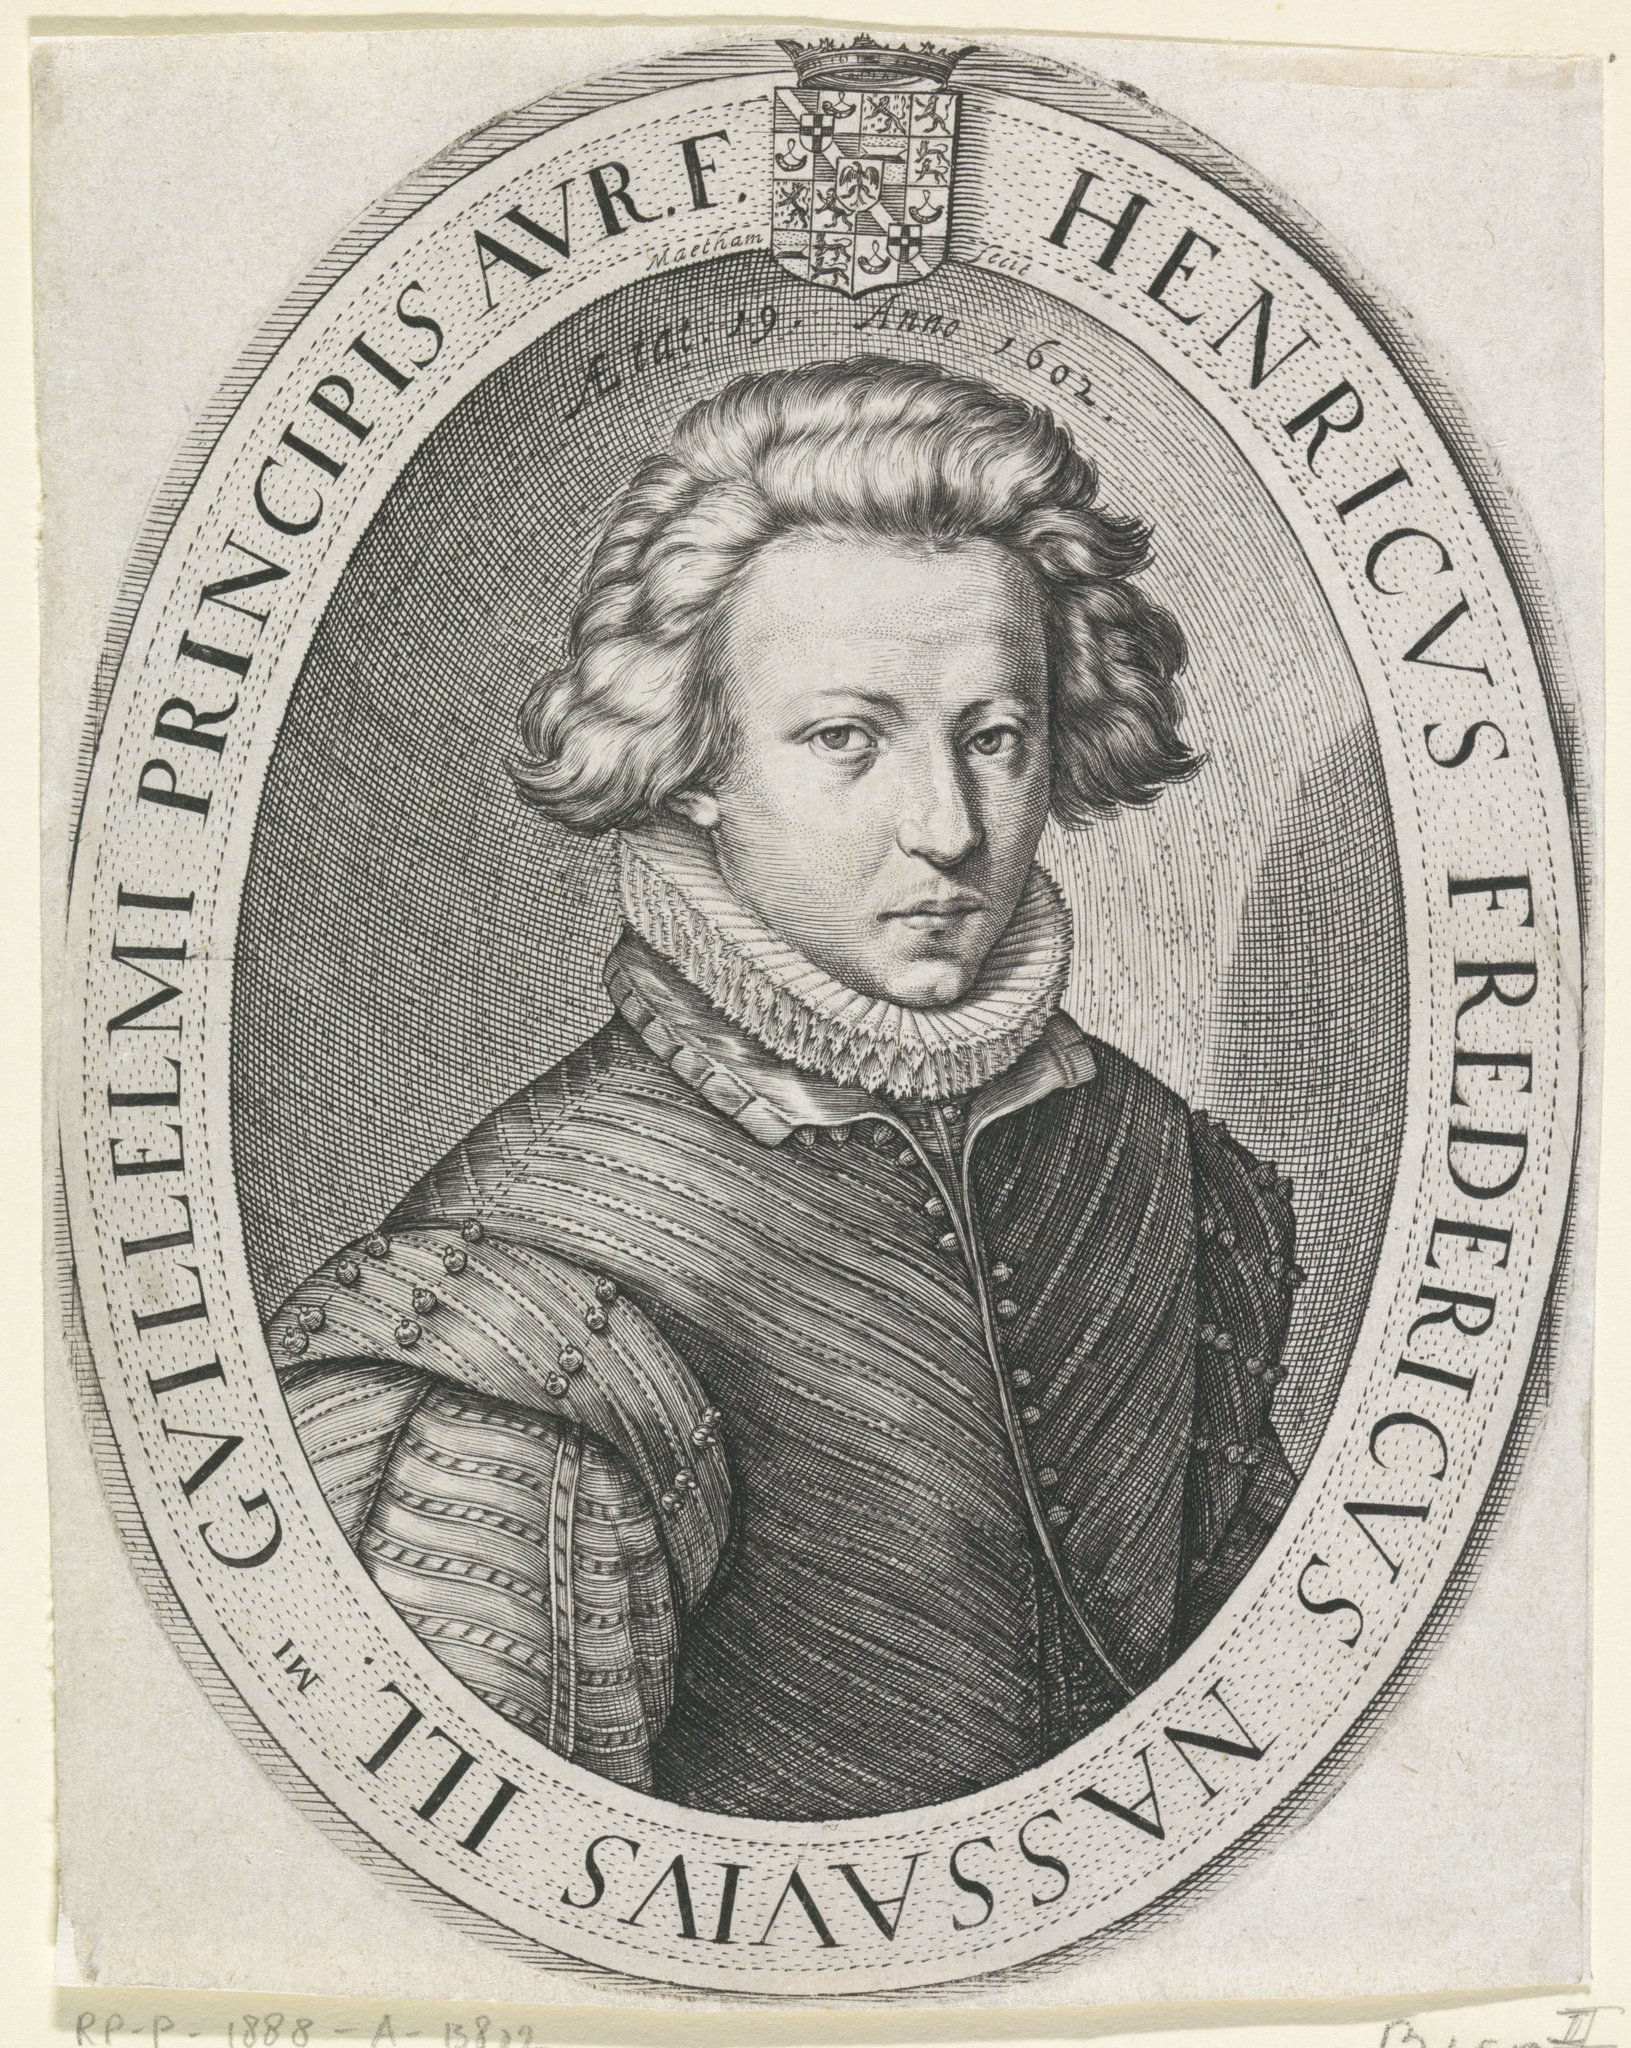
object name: print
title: Portret van Frederik Hendrik, prins van Oranje, op 19-jarige leeftijd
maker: jacob matham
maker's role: draughtsman, print maker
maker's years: 1571-1631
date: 1598-1631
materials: paper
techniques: engraving, etching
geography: haarlem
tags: delft, frederick henry (prince of orange)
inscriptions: collector's mark: Lugt 2228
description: De hier vermelde titel verwijst naar de hoogst verkregen titel van de geportretteerde, niet per se naar de titel die de geportretteerde op deze voorstelling draagt.